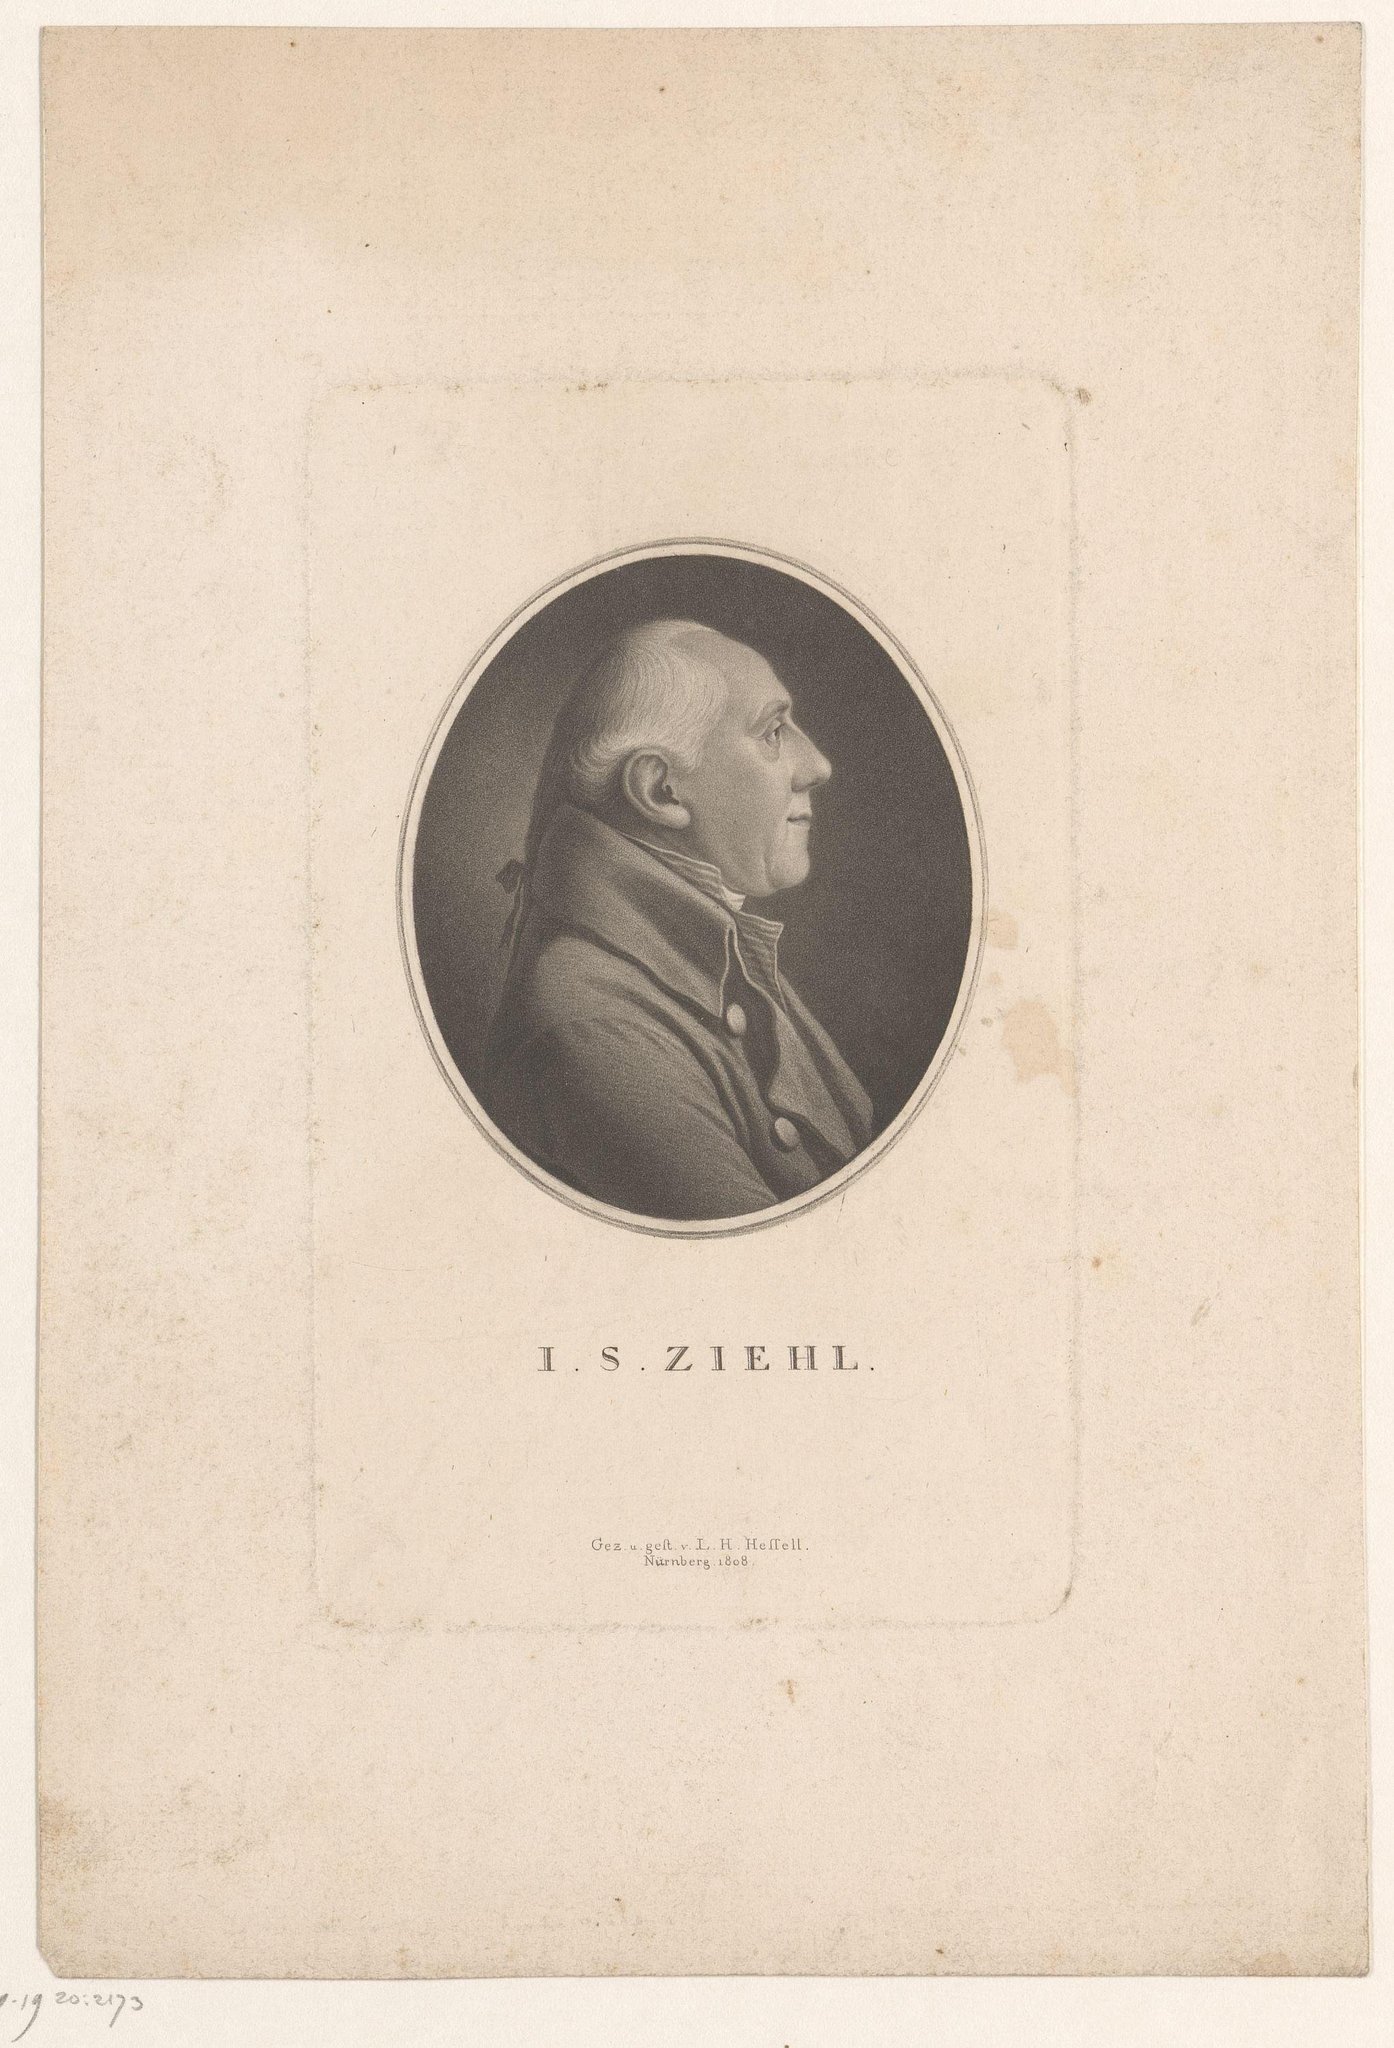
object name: print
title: Portret van I.S. Ziehl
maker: leonhard heinrich hessell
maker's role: musical instrument maker, painter, print maker, publisher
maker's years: 1757-1830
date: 1808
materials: paper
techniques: aquatint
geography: nuremberg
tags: historical persons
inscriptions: collector's mark: Lugt 2228